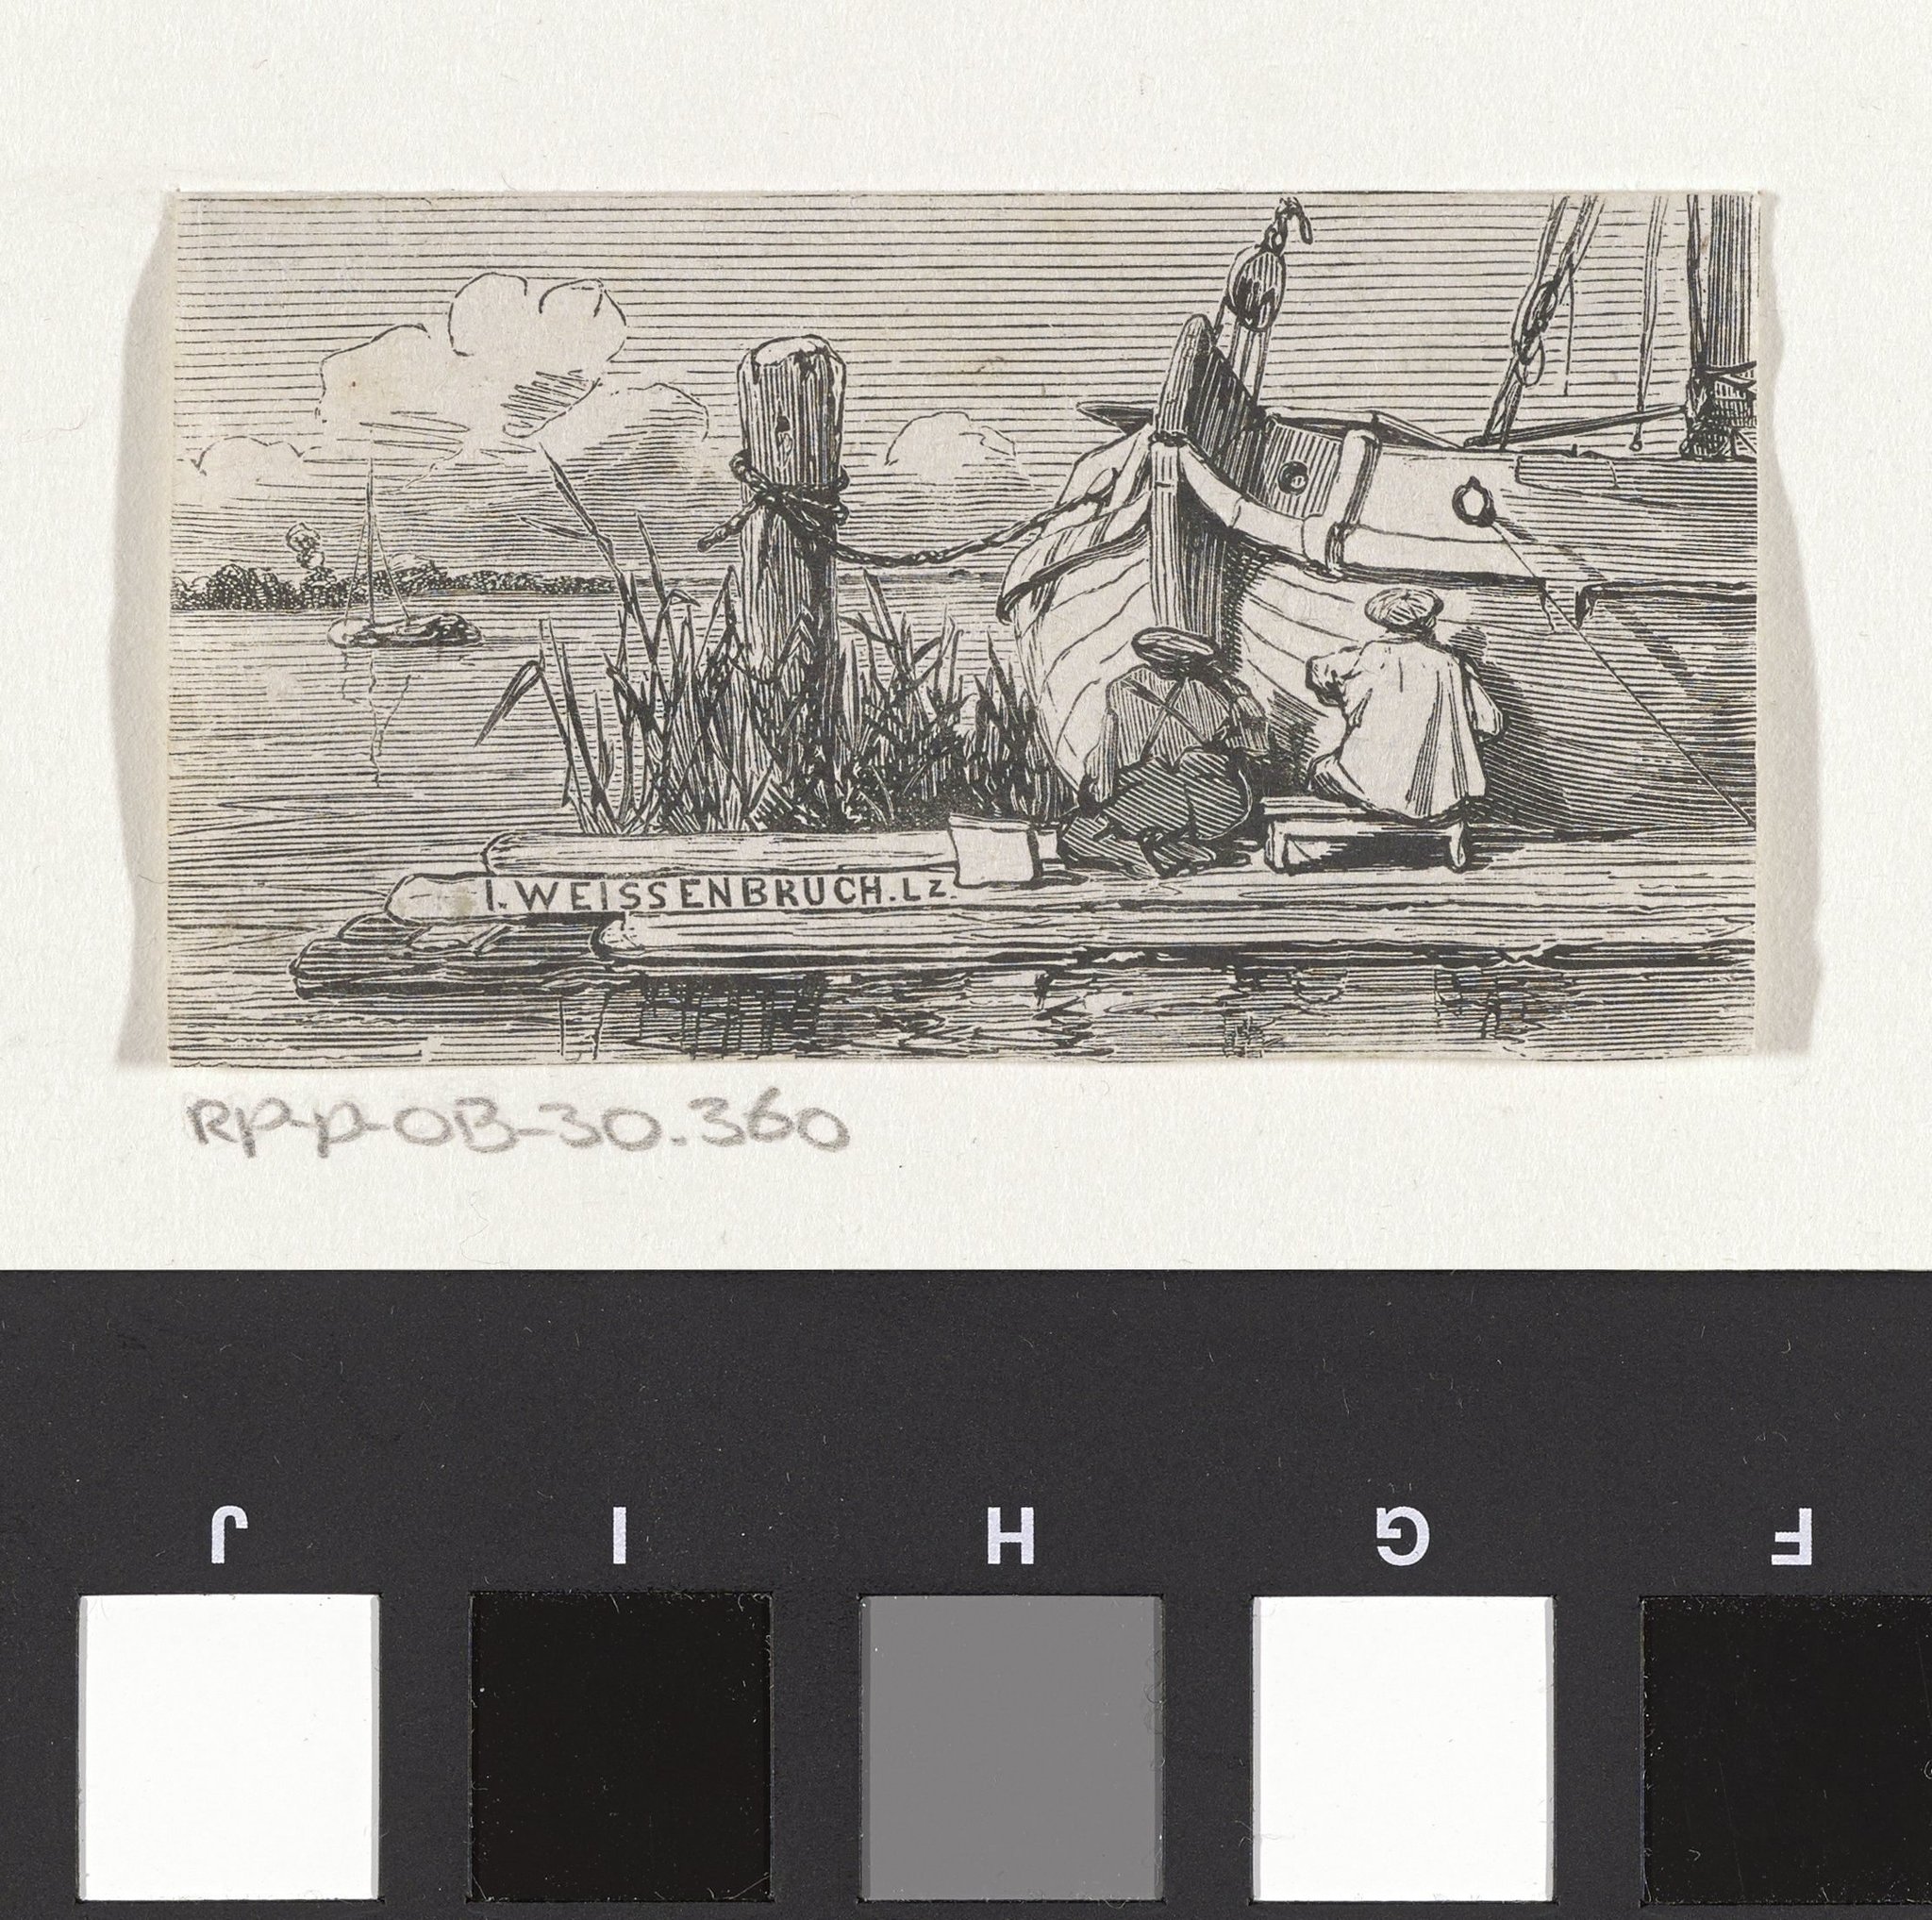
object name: print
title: Schip in reparatie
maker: isaac weissenbruch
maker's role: print maker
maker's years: 1826-1912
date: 1836-1912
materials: paper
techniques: engraving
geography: netherlands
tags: repairing, caulking, careening (~ ship)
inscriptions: collector's mark: Lugt 2166, collector's mark: Lugt 2228